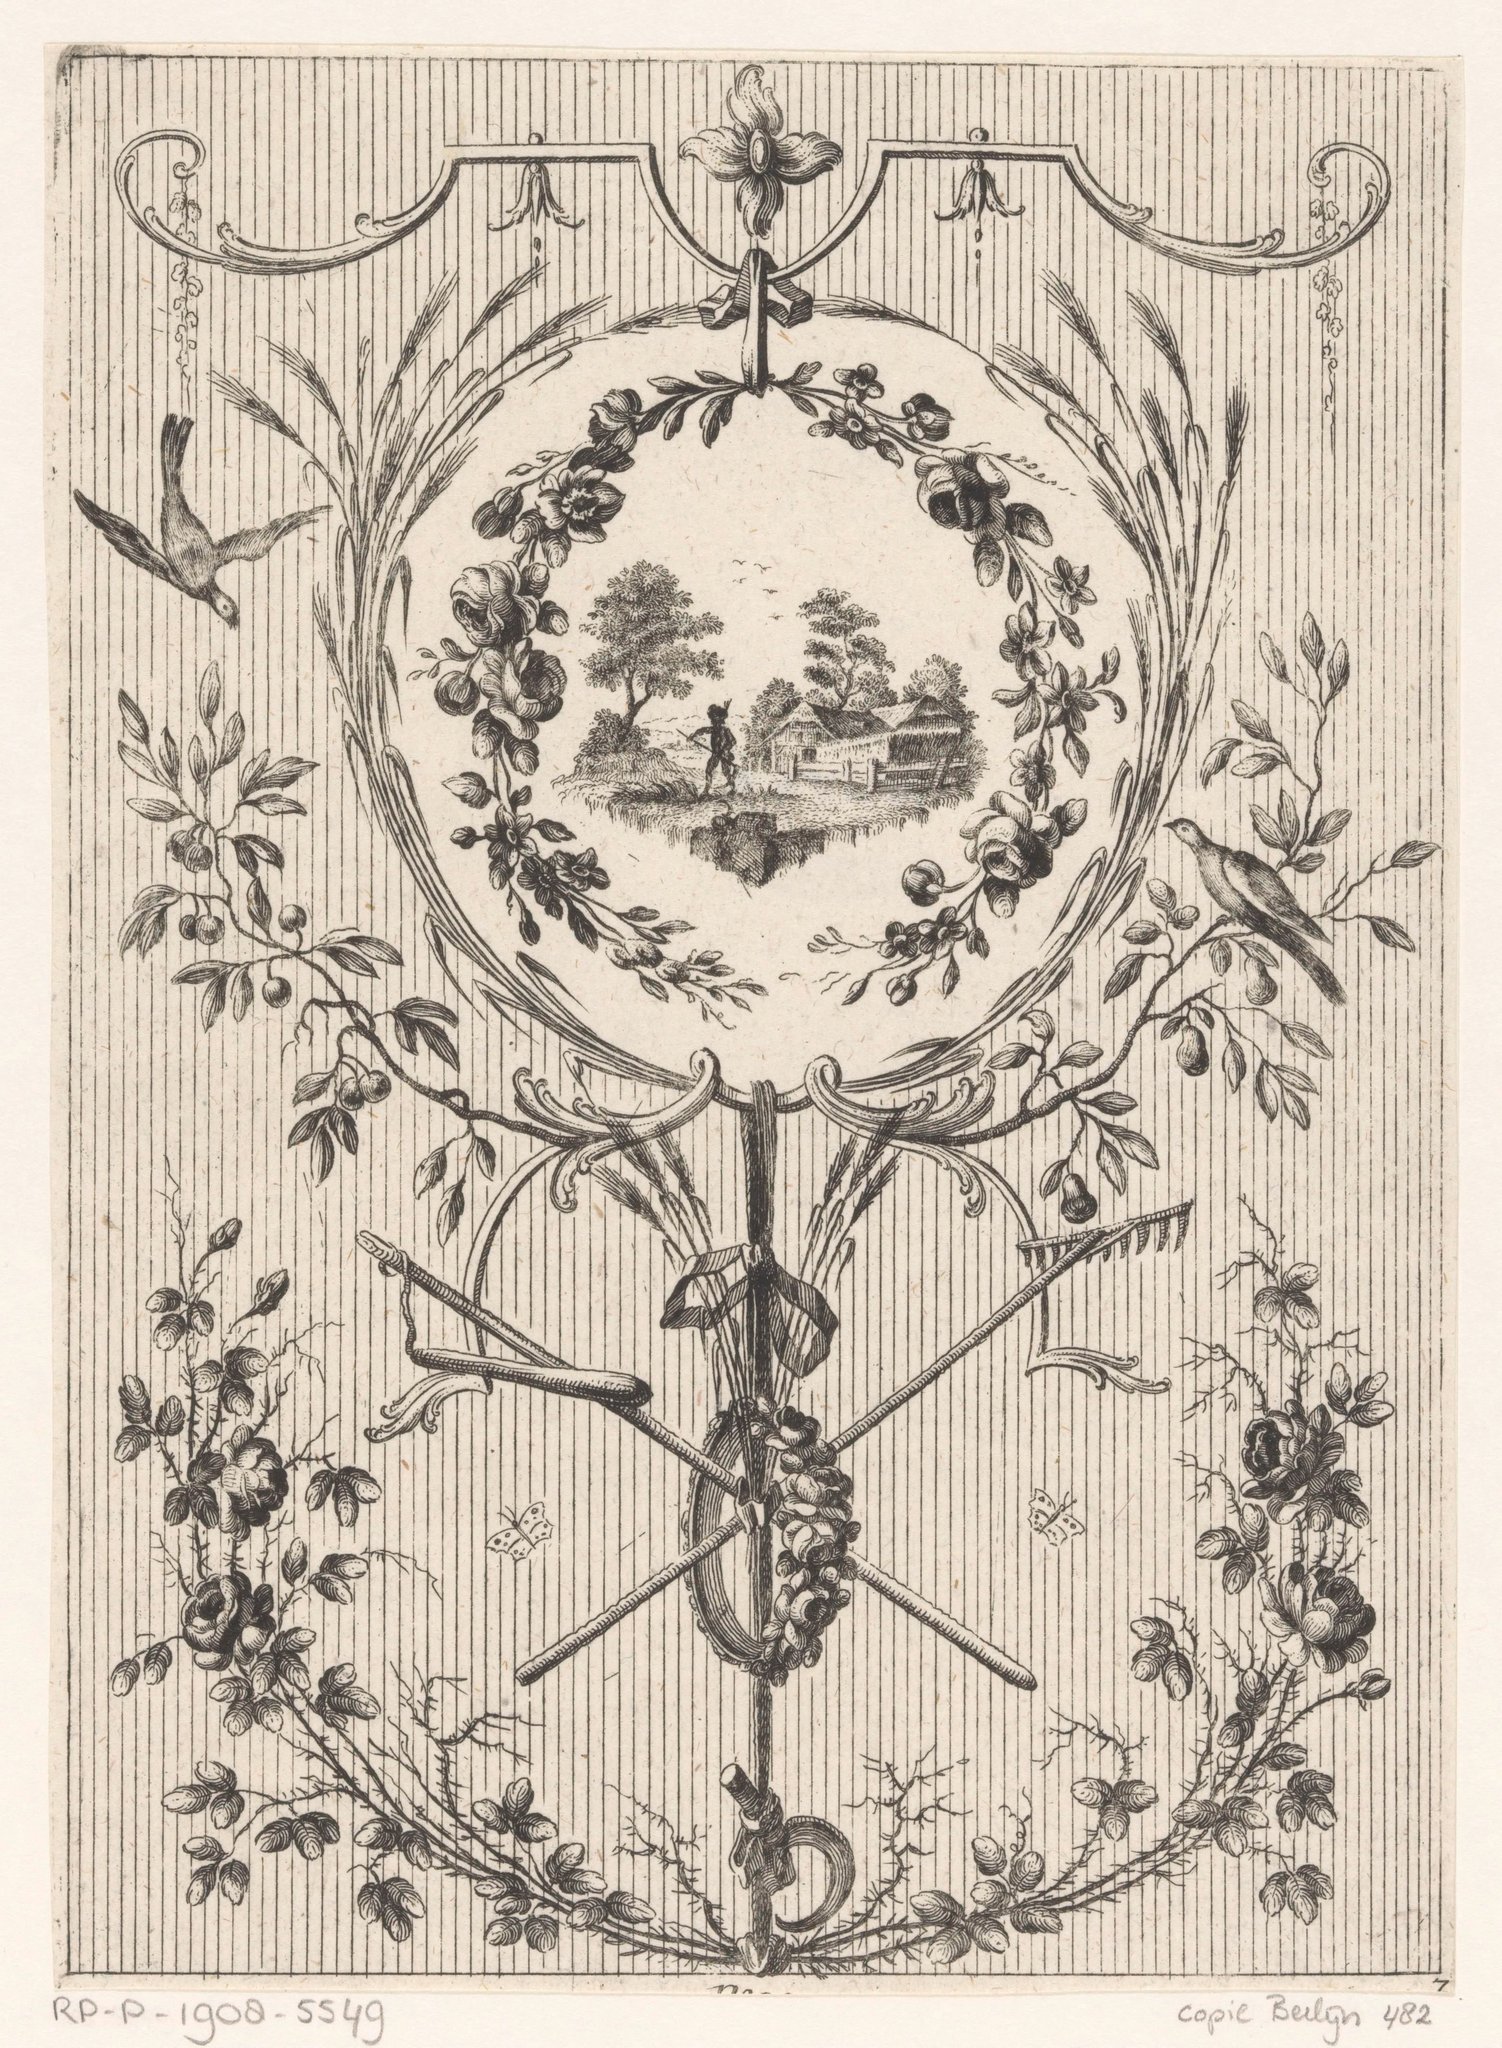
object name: ornament print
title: Medaillon met man met mand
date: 1746-1775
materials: paper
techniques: etching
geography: augsburg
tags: standing figure, ornament ~ medallion, carrying something in basket, bag, rucksack, etc.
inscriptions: collector's mark: Lugt 2228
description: Een rond medaillon met druivenranken en een voorstelling van een man met een stok en een mand op zijn rug. Rondom rocaille ornamenten en takken met eikels en vruchten.